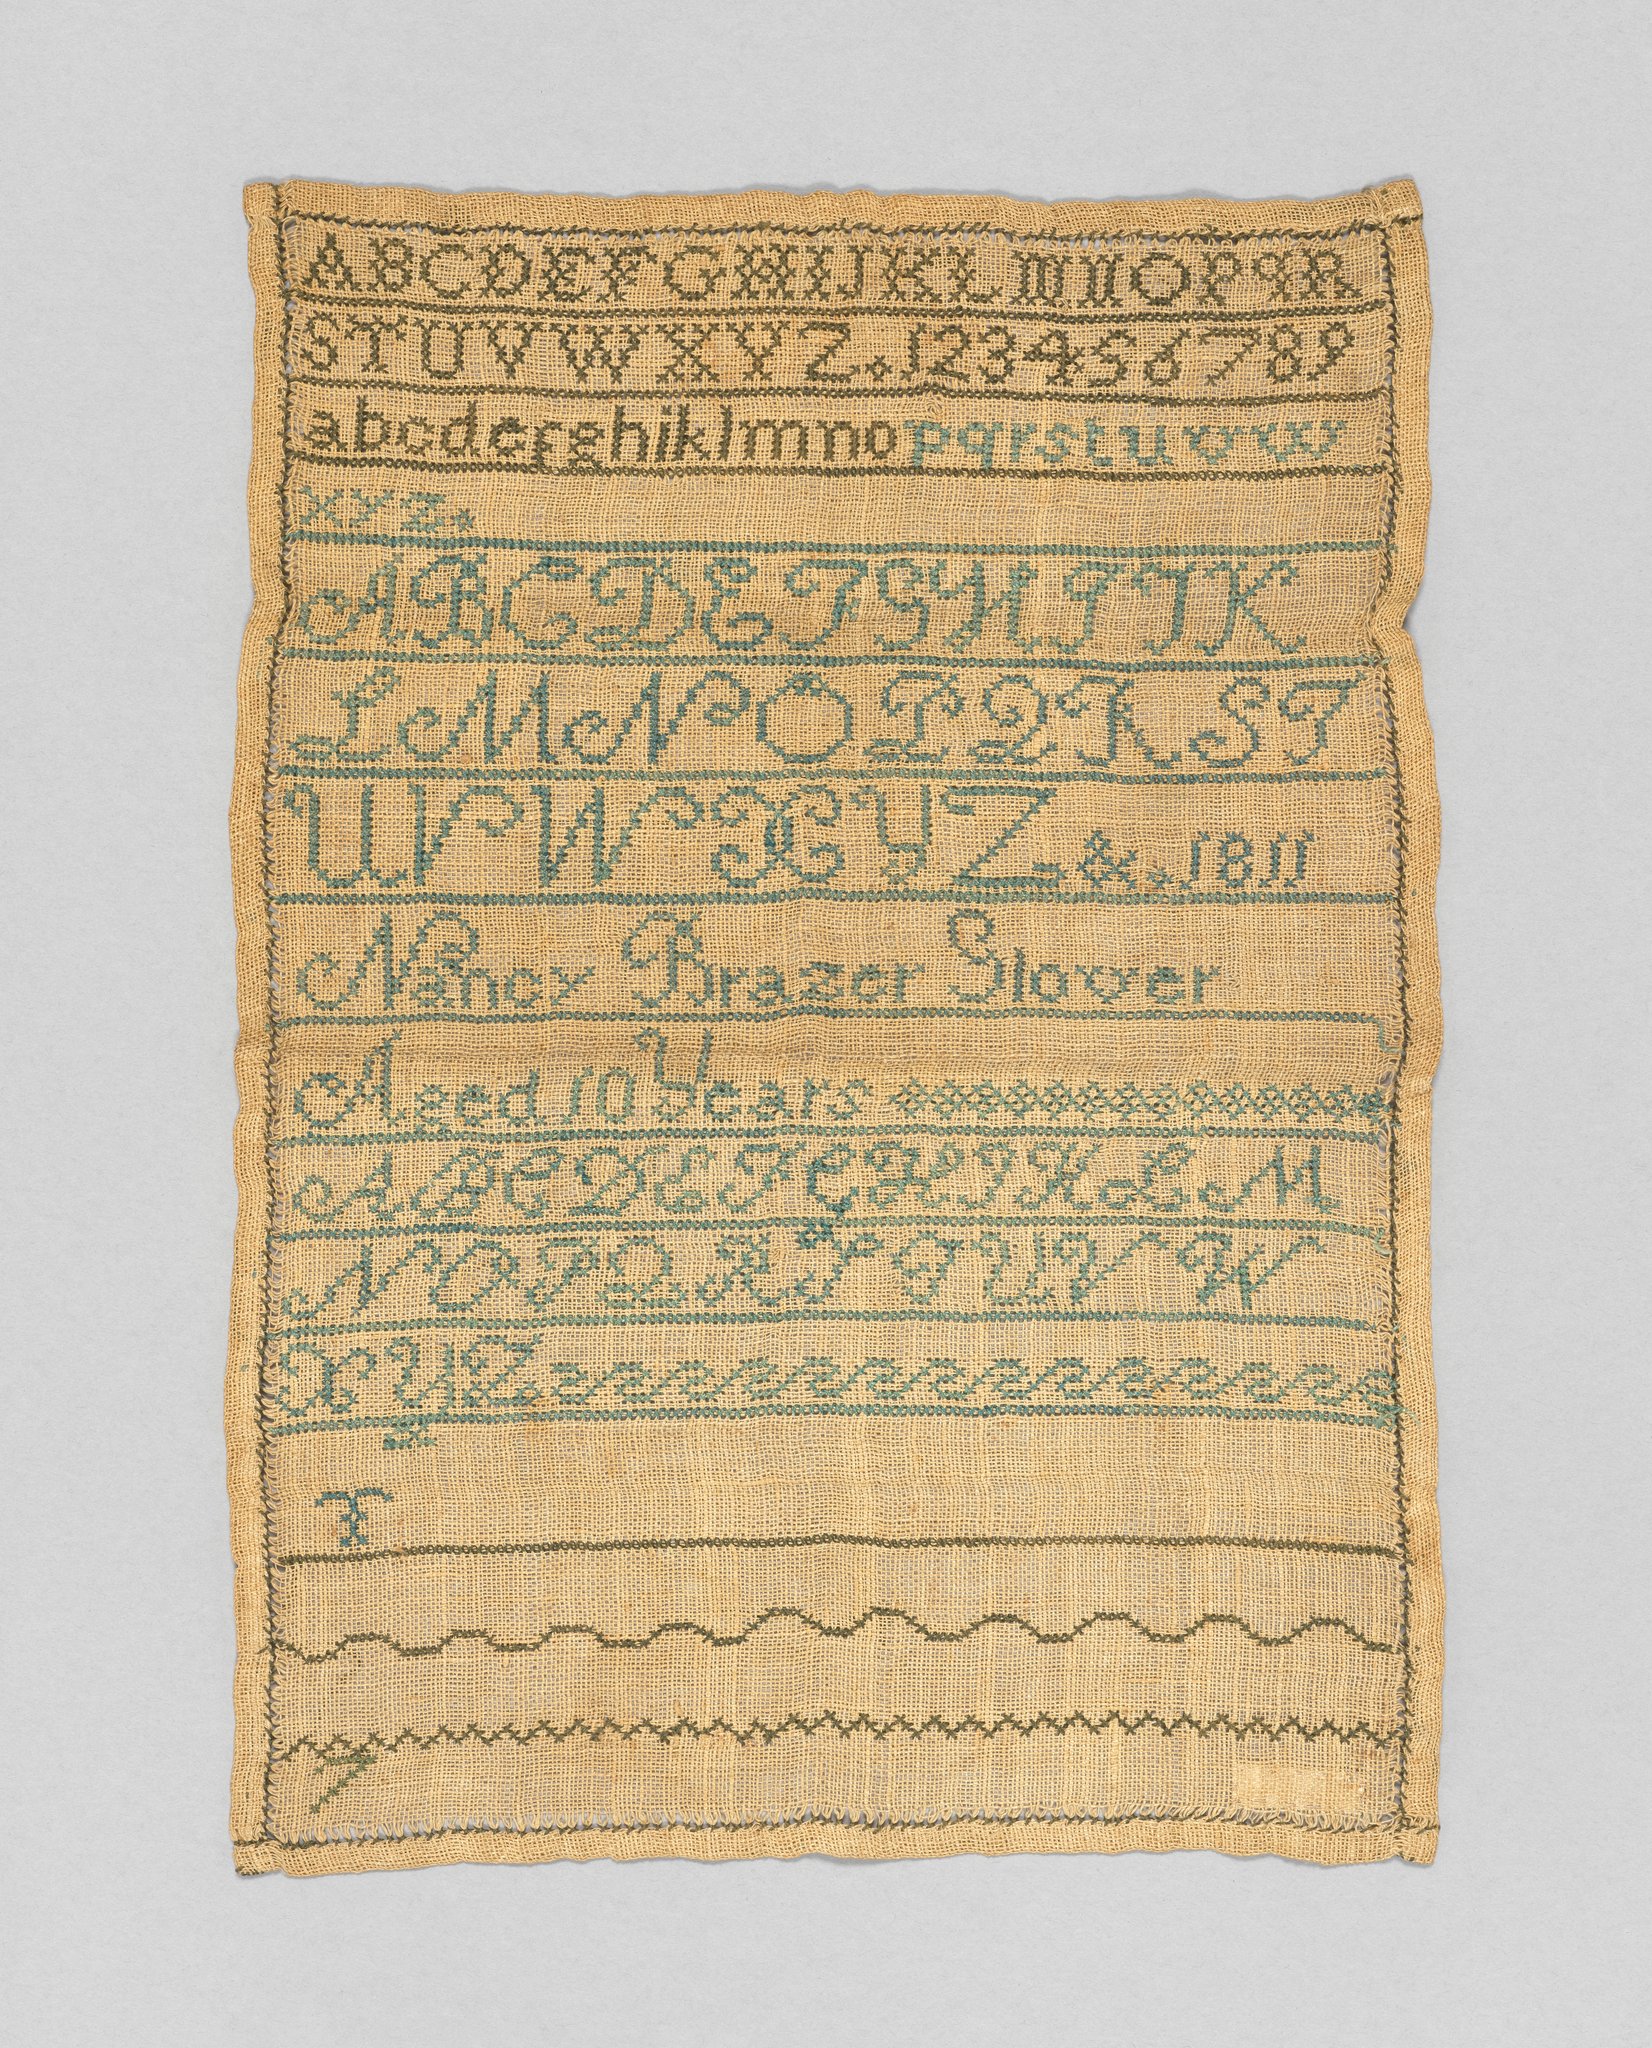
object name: sampler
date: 1701-1800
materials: silk, wool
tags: peacocks,flowers